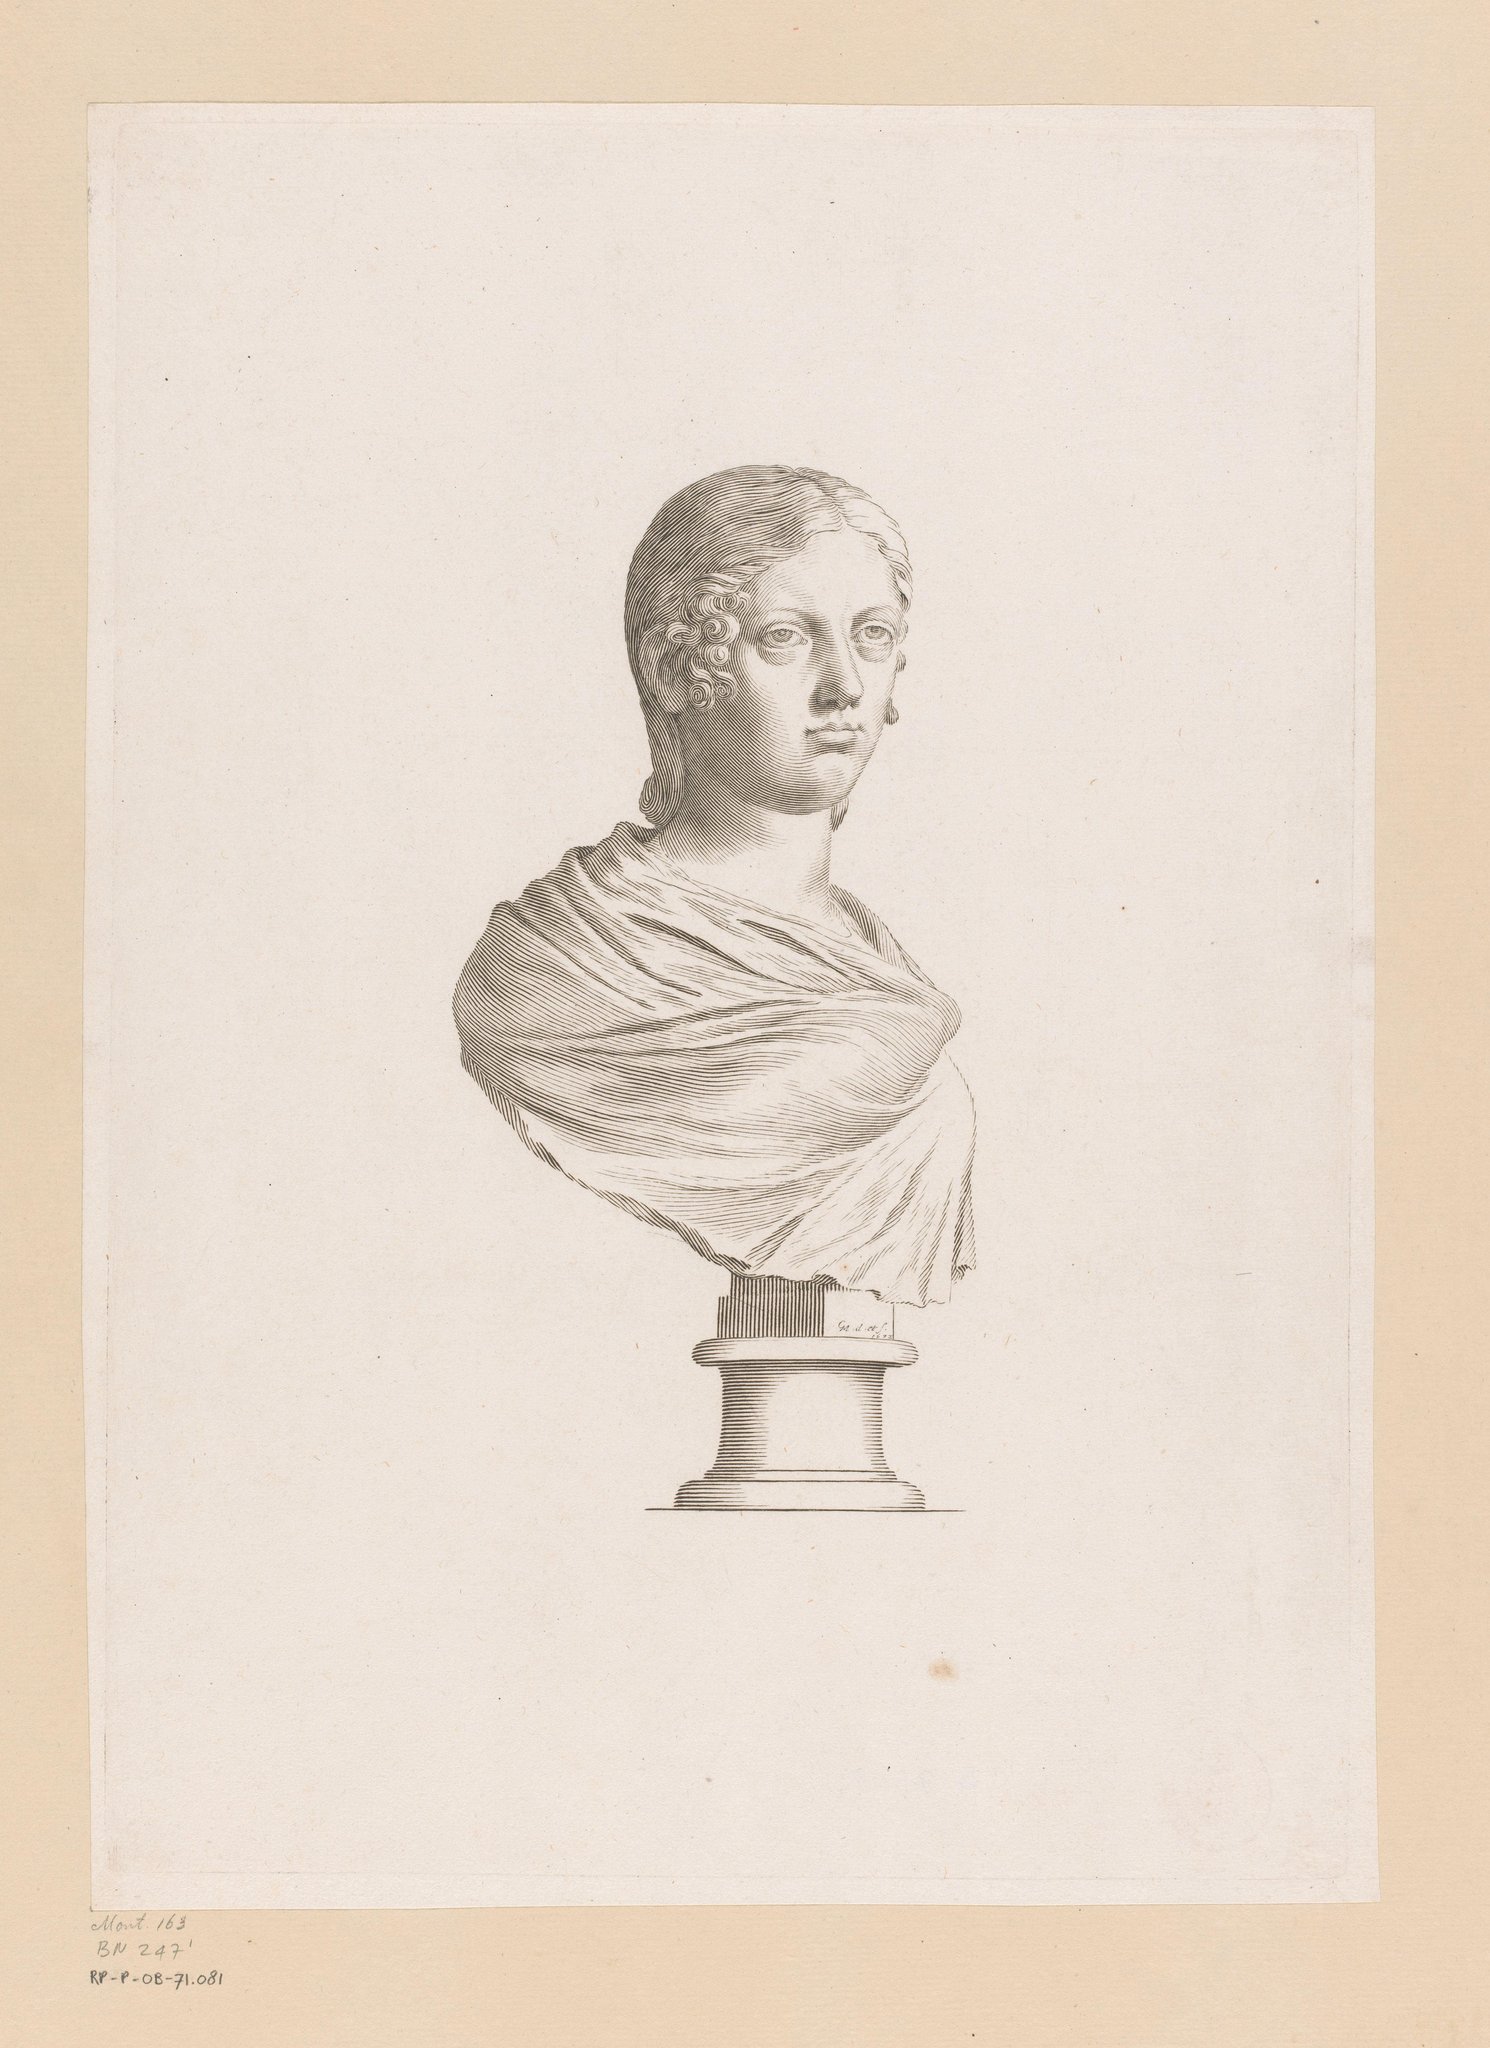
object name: print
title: Buste van een Romeinse dame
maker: claude mellan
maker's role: draughtsman, print maker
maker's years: 1598-1688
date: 1672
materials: paper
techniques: engraving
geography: france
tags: piece of sculpture, reproduction of a piece of sculpture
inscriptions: collector's mark: Lugt 240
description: Prent gebruikt voor: Félibien, André. Tableaux du Cabinet du roy. Statues et bustes antiques des maisons royales. Parijs: Imprimerie Royale, 1677. Het boek bevat 61 prenten van beelden en bustes uit Franse koninklijke collectie. Mellan vervaardigde in totaal achttien platen (zie ook British Museum, inv.nr. 1874,0808.1488). De verblijfplaats van het beeld is onbekend.